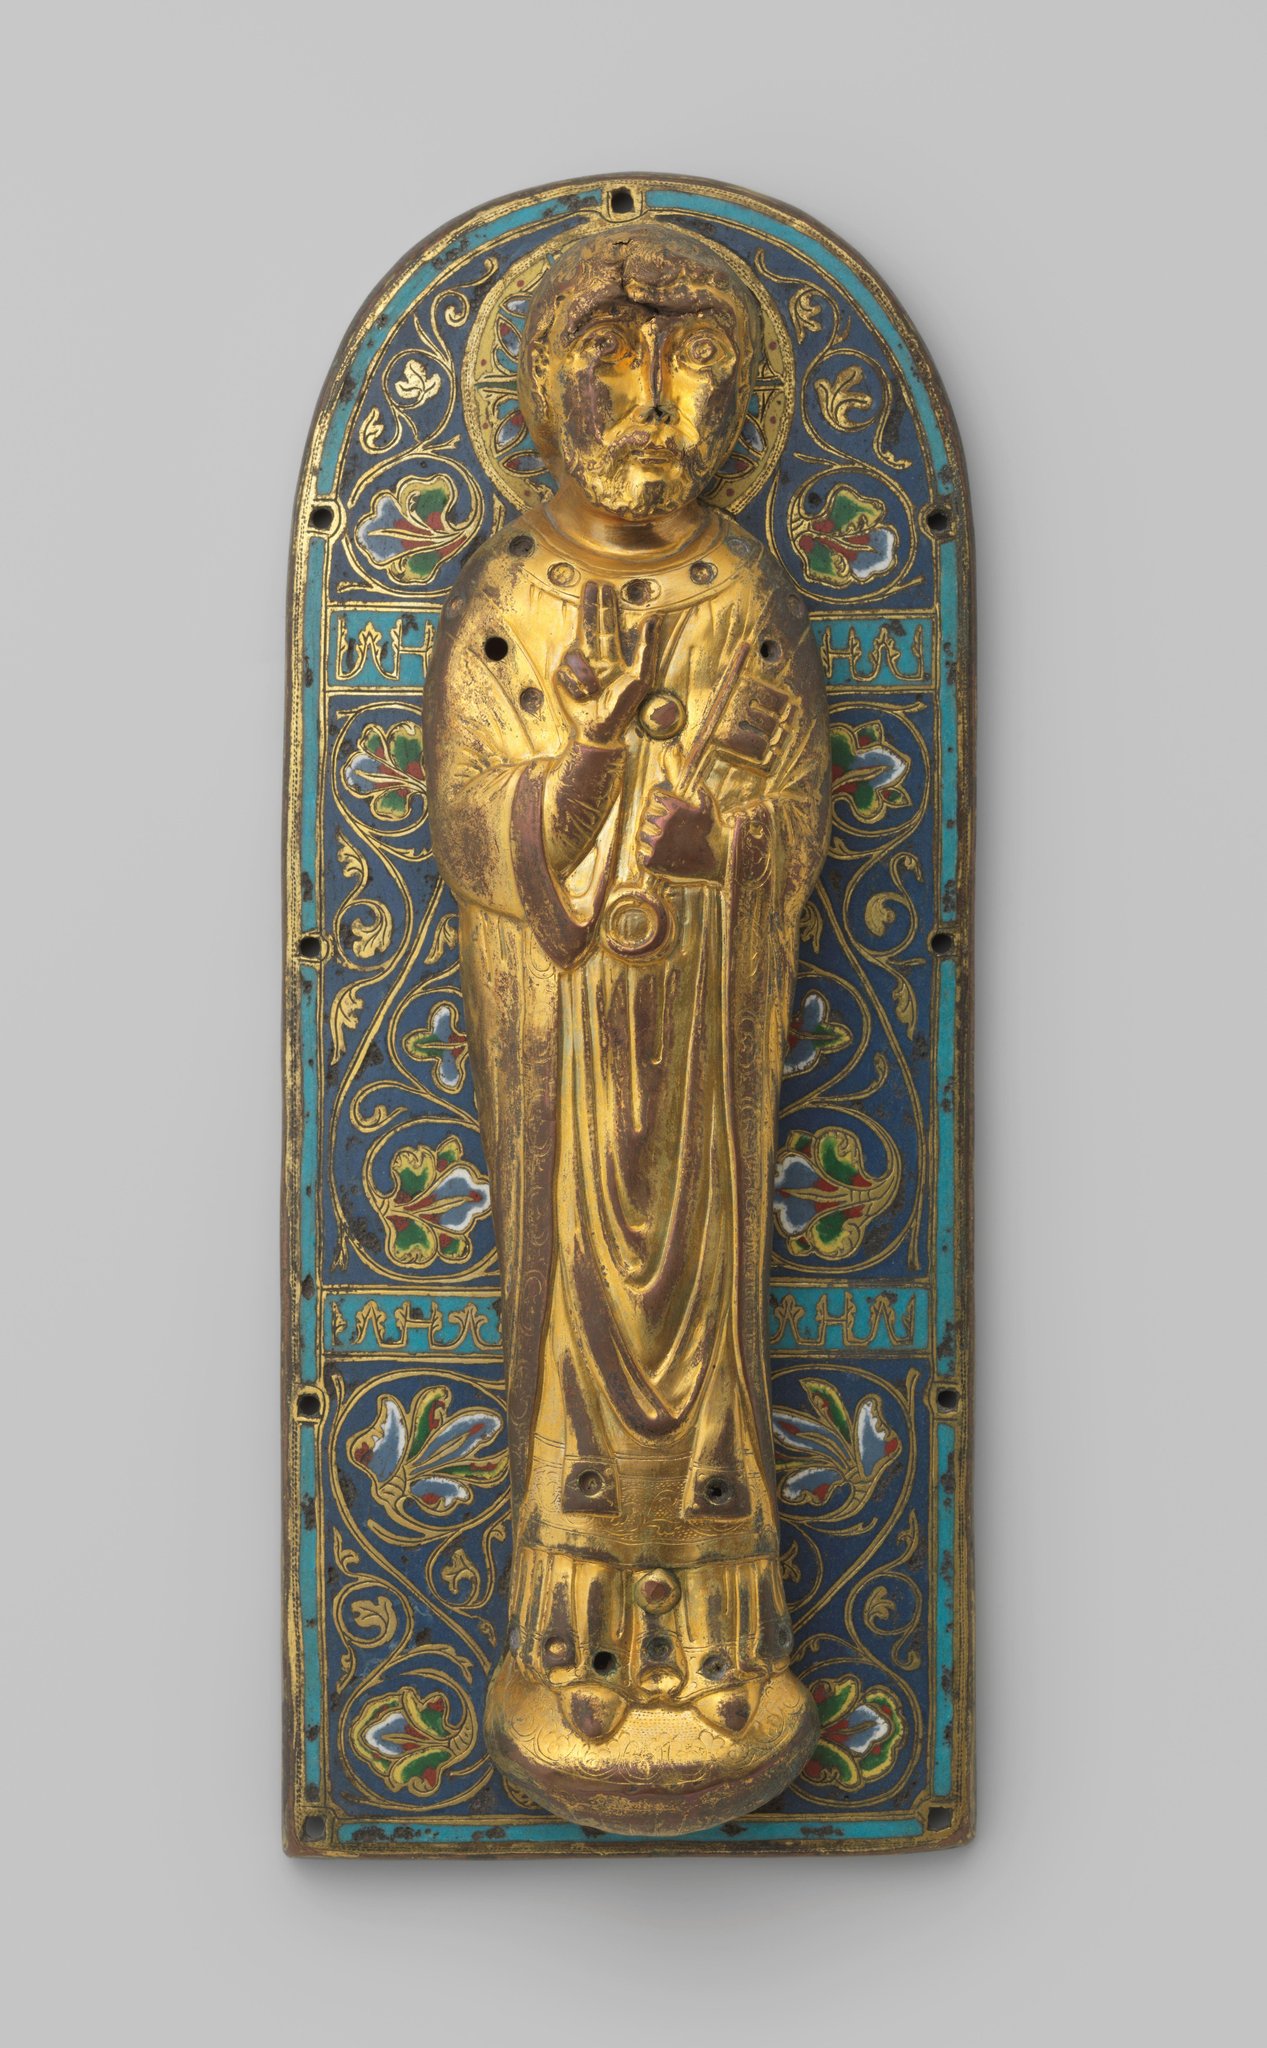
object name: altar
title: Altaarfragment met voorstelling van Petrus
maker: Anonymous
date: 1190-1200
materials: copper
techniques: enamel, gilding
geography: limoges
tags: the apostle peter, first bishop of rome; possible attributes: book, cock, (upturned) cross, (triple) crozier, fish, key, scroll, ship, tiara - portrait of male saint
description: St Peter. Fragment from an altar. 13th century.